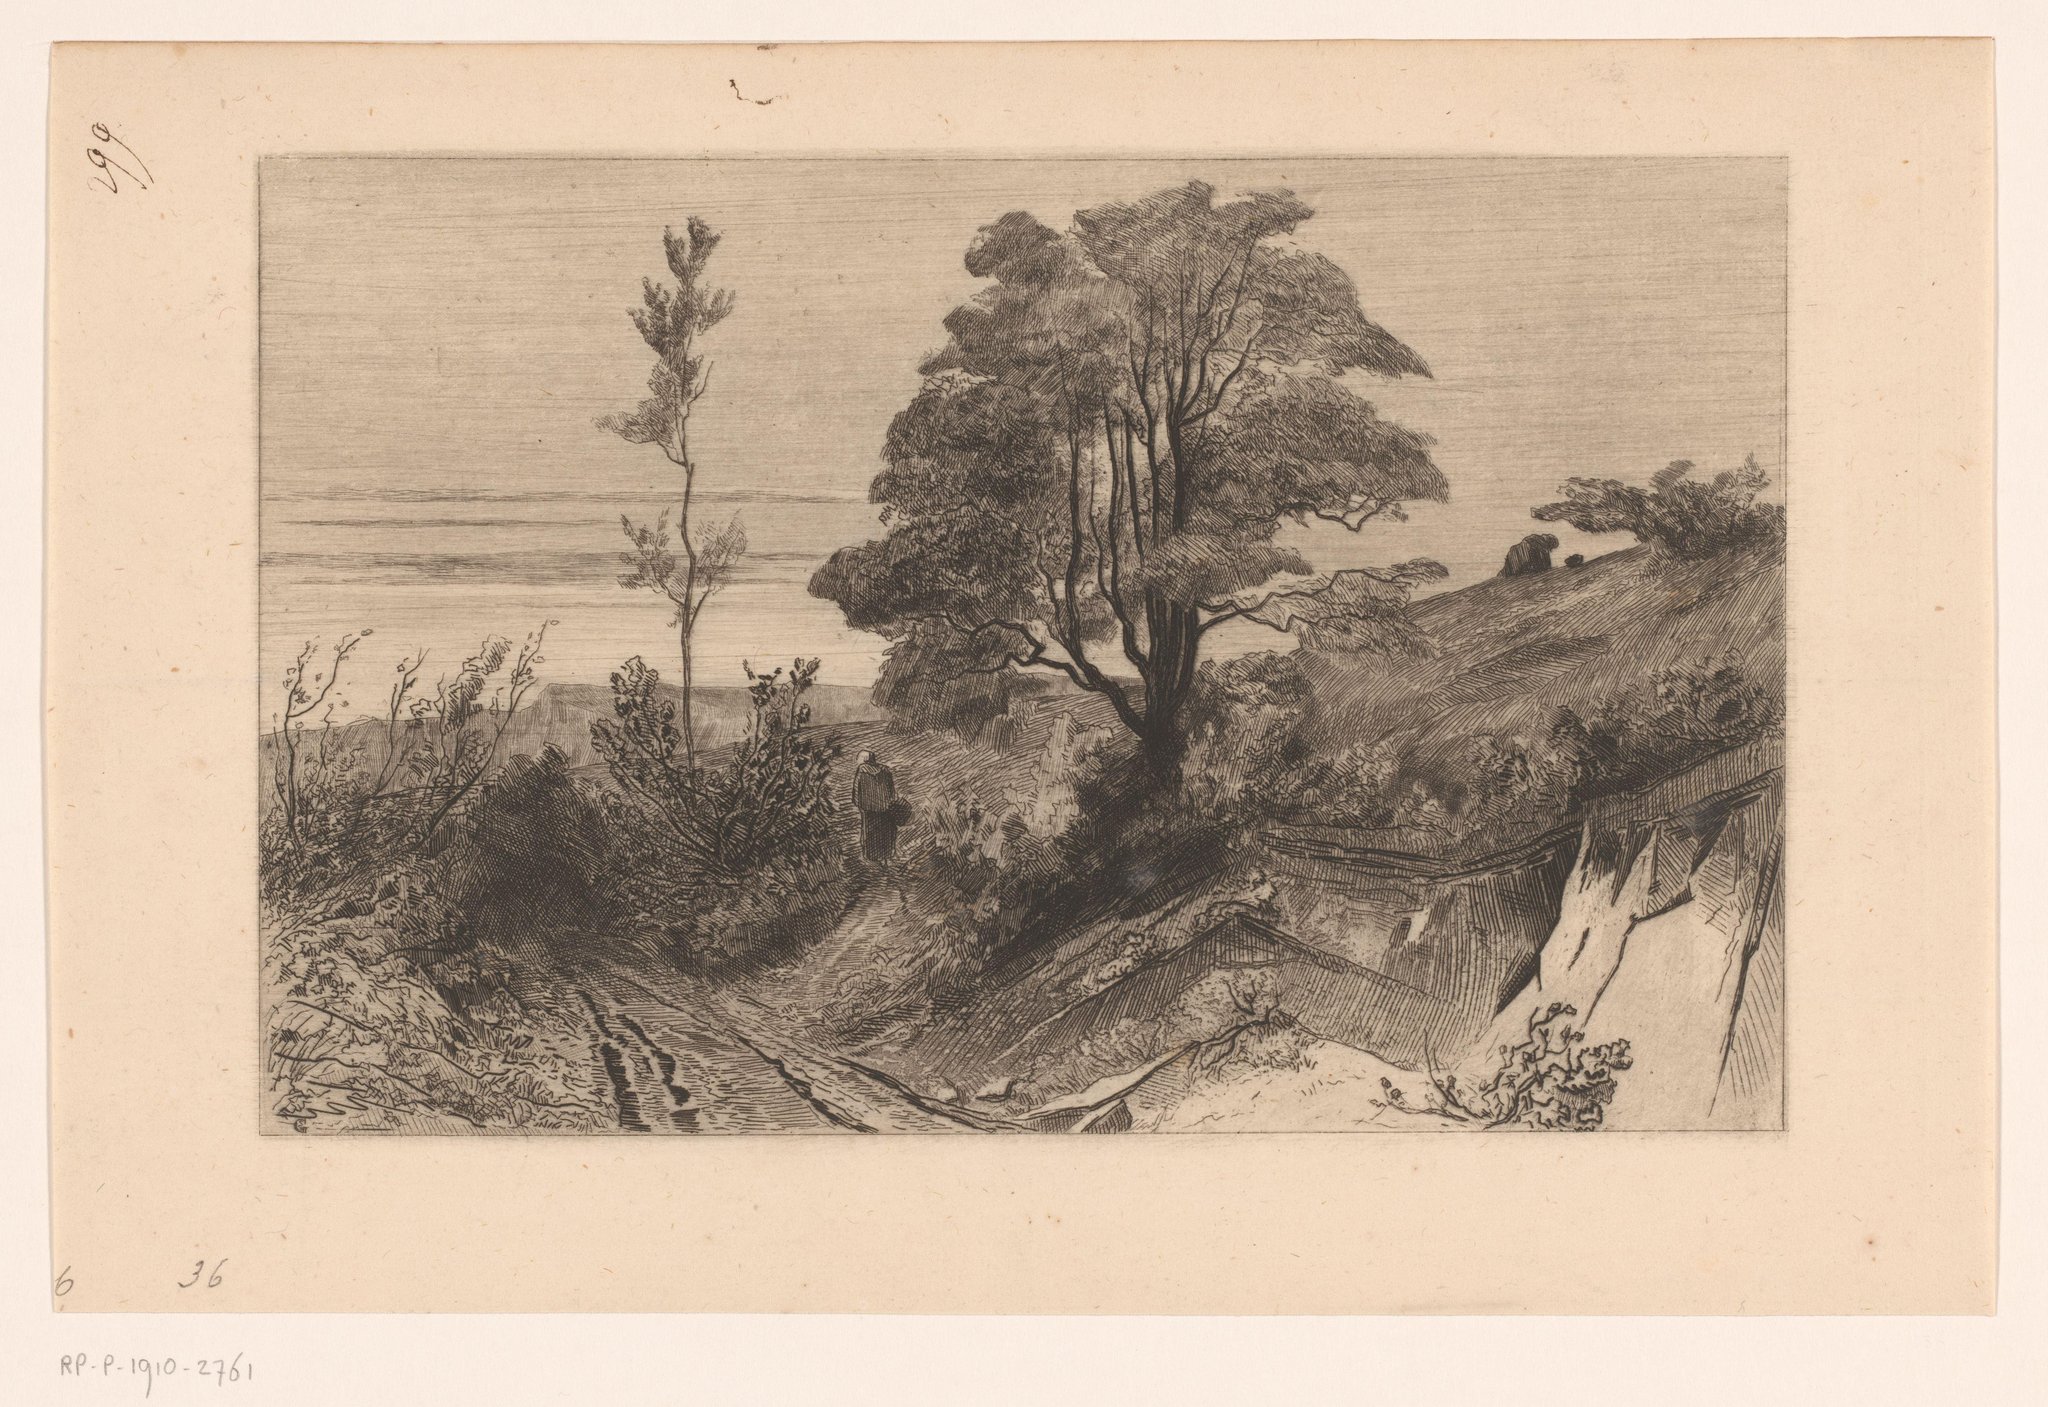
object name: print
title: Souvenir de Moulins-Warnaut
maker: carel nicolaas storm van s-gravesande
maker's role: draughtsman, print maker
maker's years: 1841-1924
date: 1872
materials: paper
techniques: etching, intaglio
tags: low hill country (+ landscape with figures, staffage), road, path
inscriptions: number: ‘299’, collector's mark: Lugt 2228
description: Landweg in heuvellandschap met bomen. In het midden loopt een figuur met een mand.